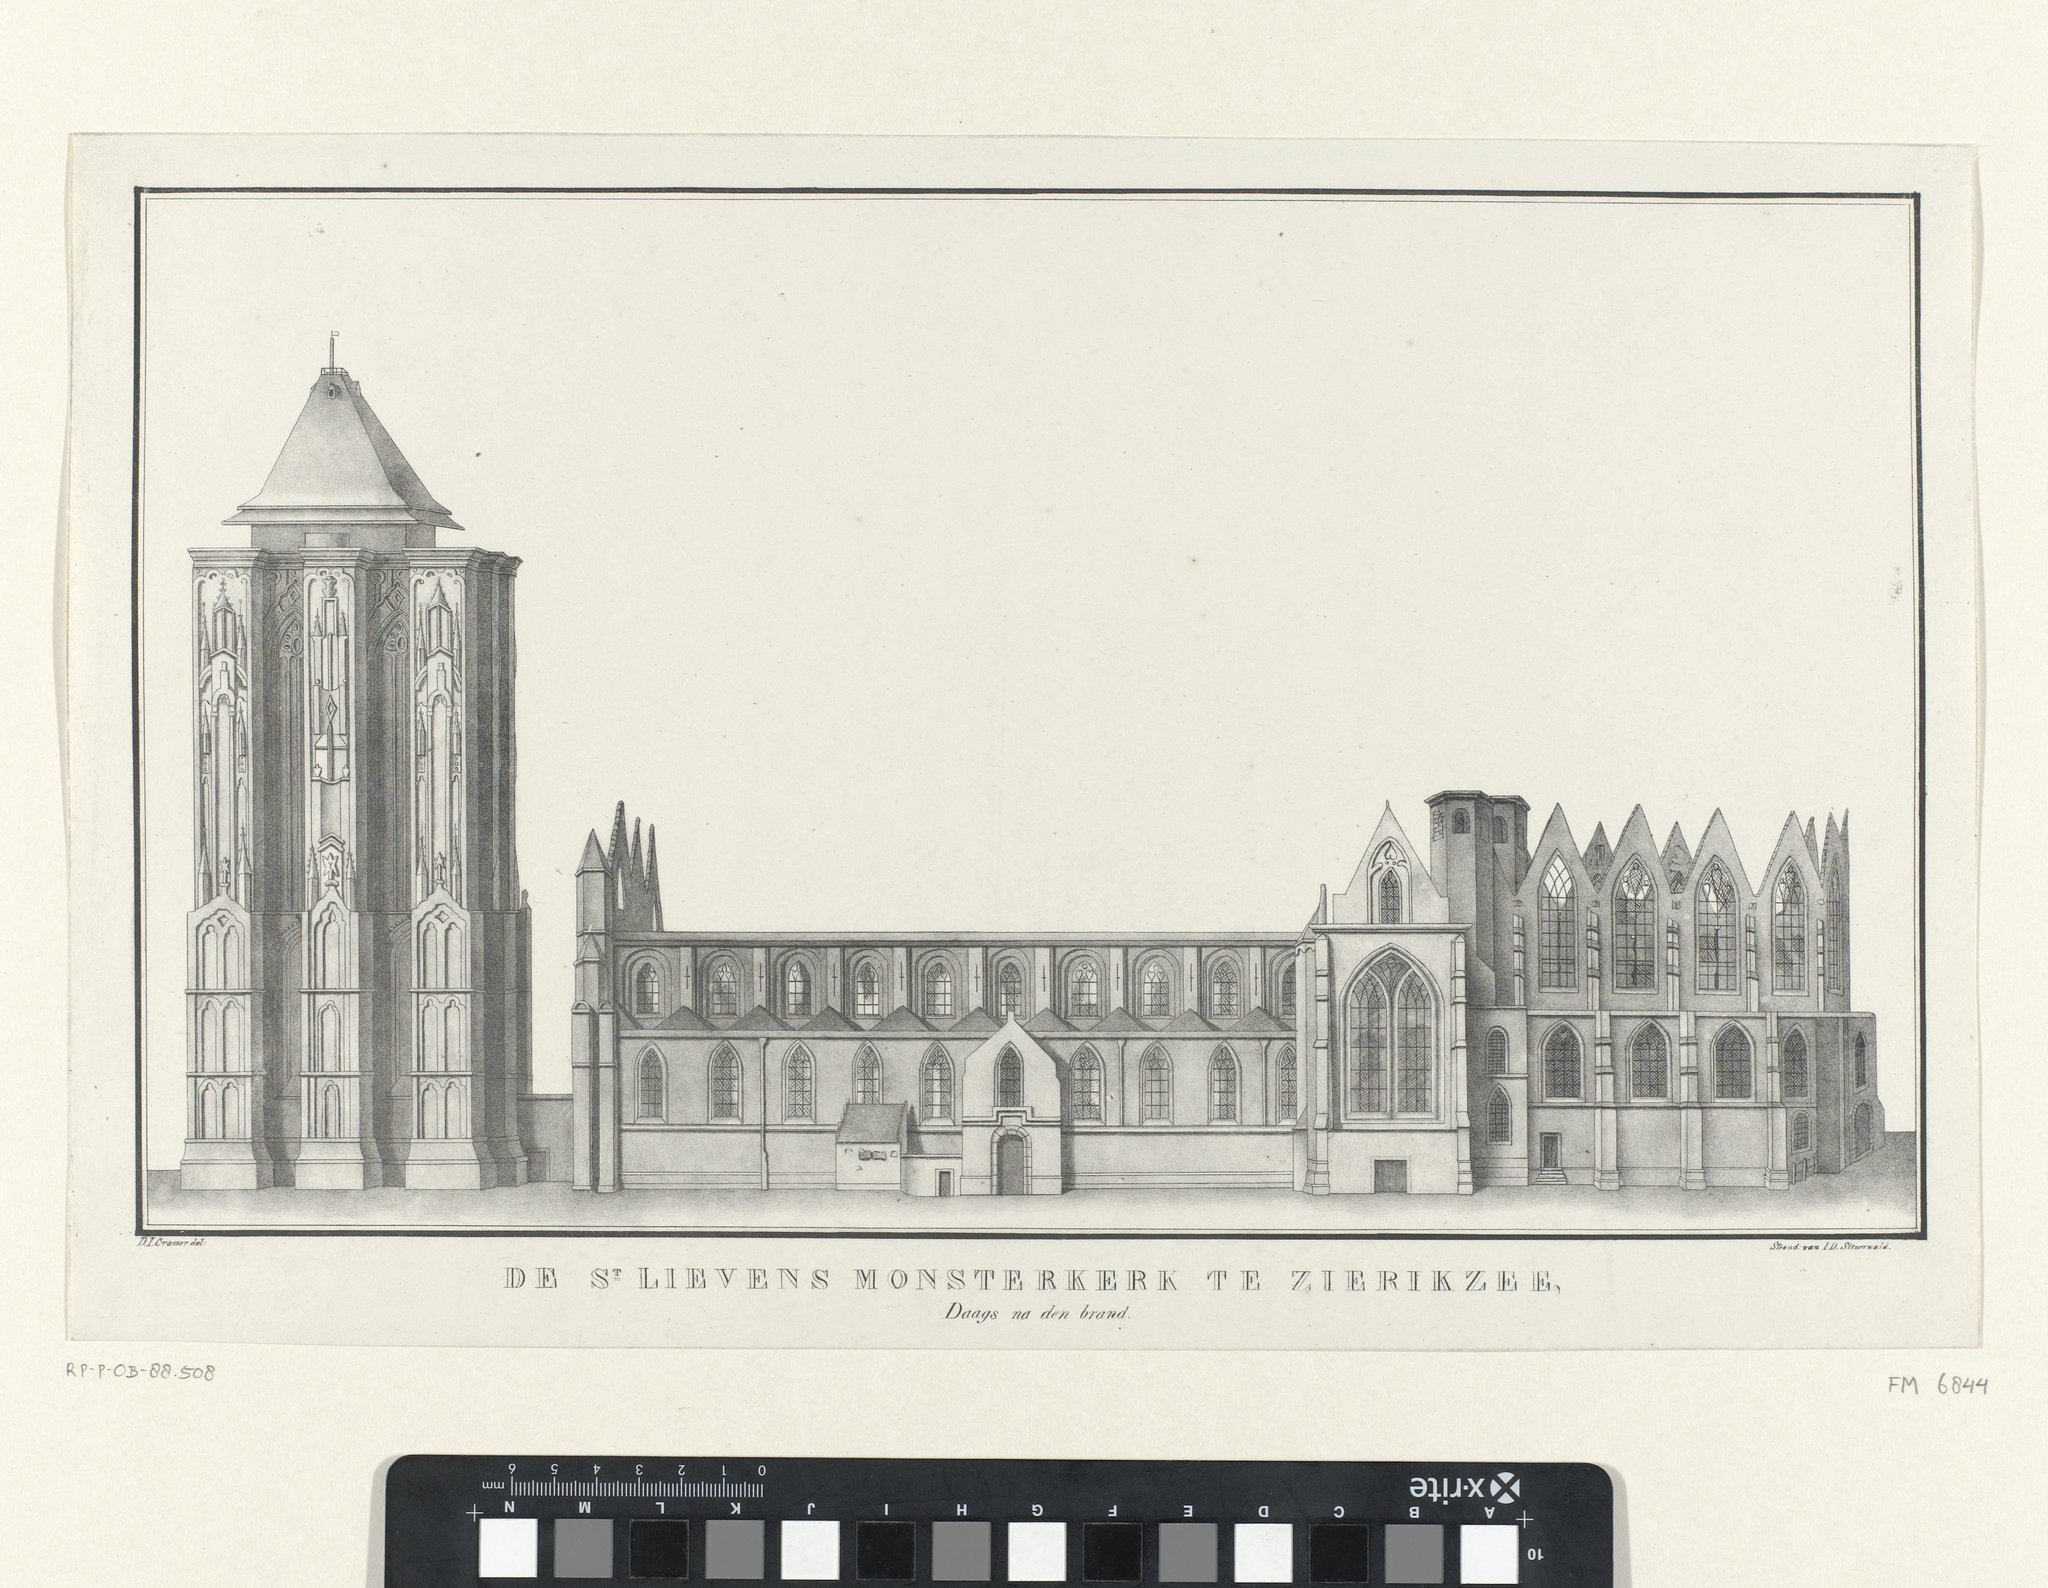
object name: print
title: De St Lievens Monsterkerk te Zierikzee, Daags na den brand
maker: jan dam steuerwald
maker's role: print maker, printer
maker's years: 1805-1869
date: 1832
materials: paper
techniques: lithograph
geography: netherlands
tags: ruin of church, monastery, etc.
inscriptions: collector's mark: Lugt 2228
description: Gezicht op het gebouw van de Sint-Lievensmonsterkerk te Zierikzee, daags na de brand van 6 oktober 1832. Links de toren die intact is gebleven, rechts het verwoeste kerkgebouw.